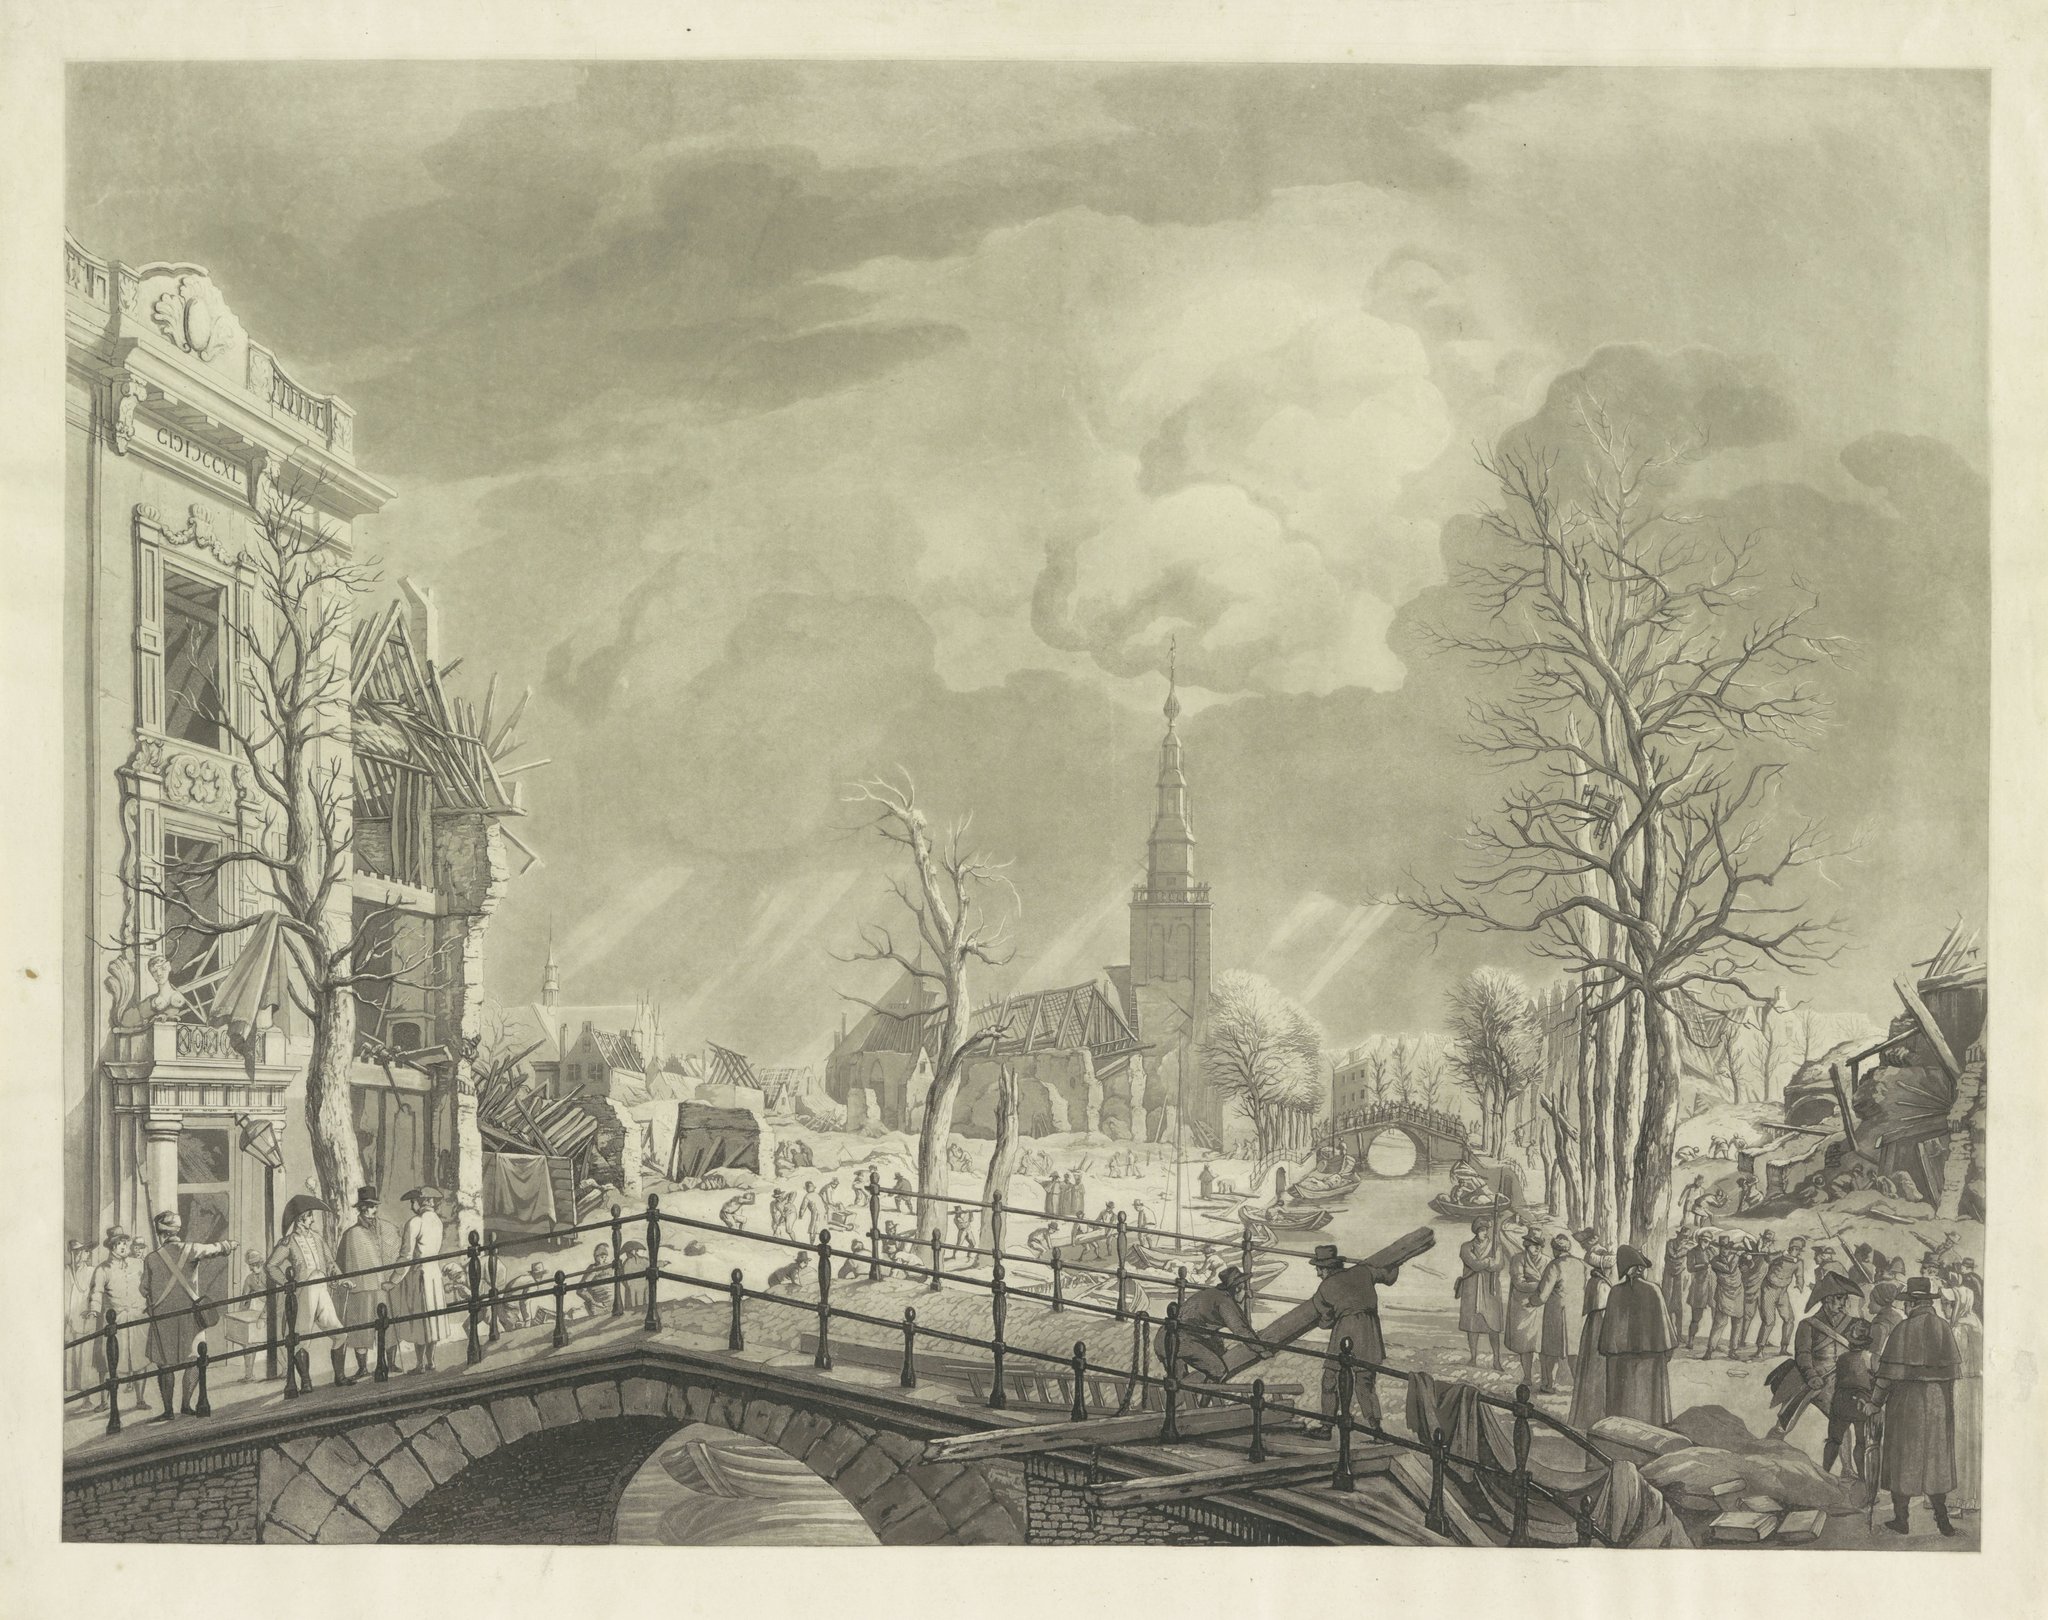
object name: print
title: Ruïnes na de buskruitramp, 1807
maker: friedrich christoph dietrich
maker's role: print maker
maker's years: 1779-1847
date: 1807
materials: paper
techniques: aquatint, etching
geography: netherlands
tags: gunpowder disaster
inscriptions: collector's mark: Lugt 2228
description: Gezicht vanaf de Nieuwsteegbrug op het verwoest gebied na de buskruitramp op het Steenschuur, een gracht in het verlengde van het Rapenburg, te Leiden op 12 januari 1807. Opruimwerkzaamheden na de ramp, het wegdragen van slachtoffers. Centraal de Saaihal. Zie ook de pendant.